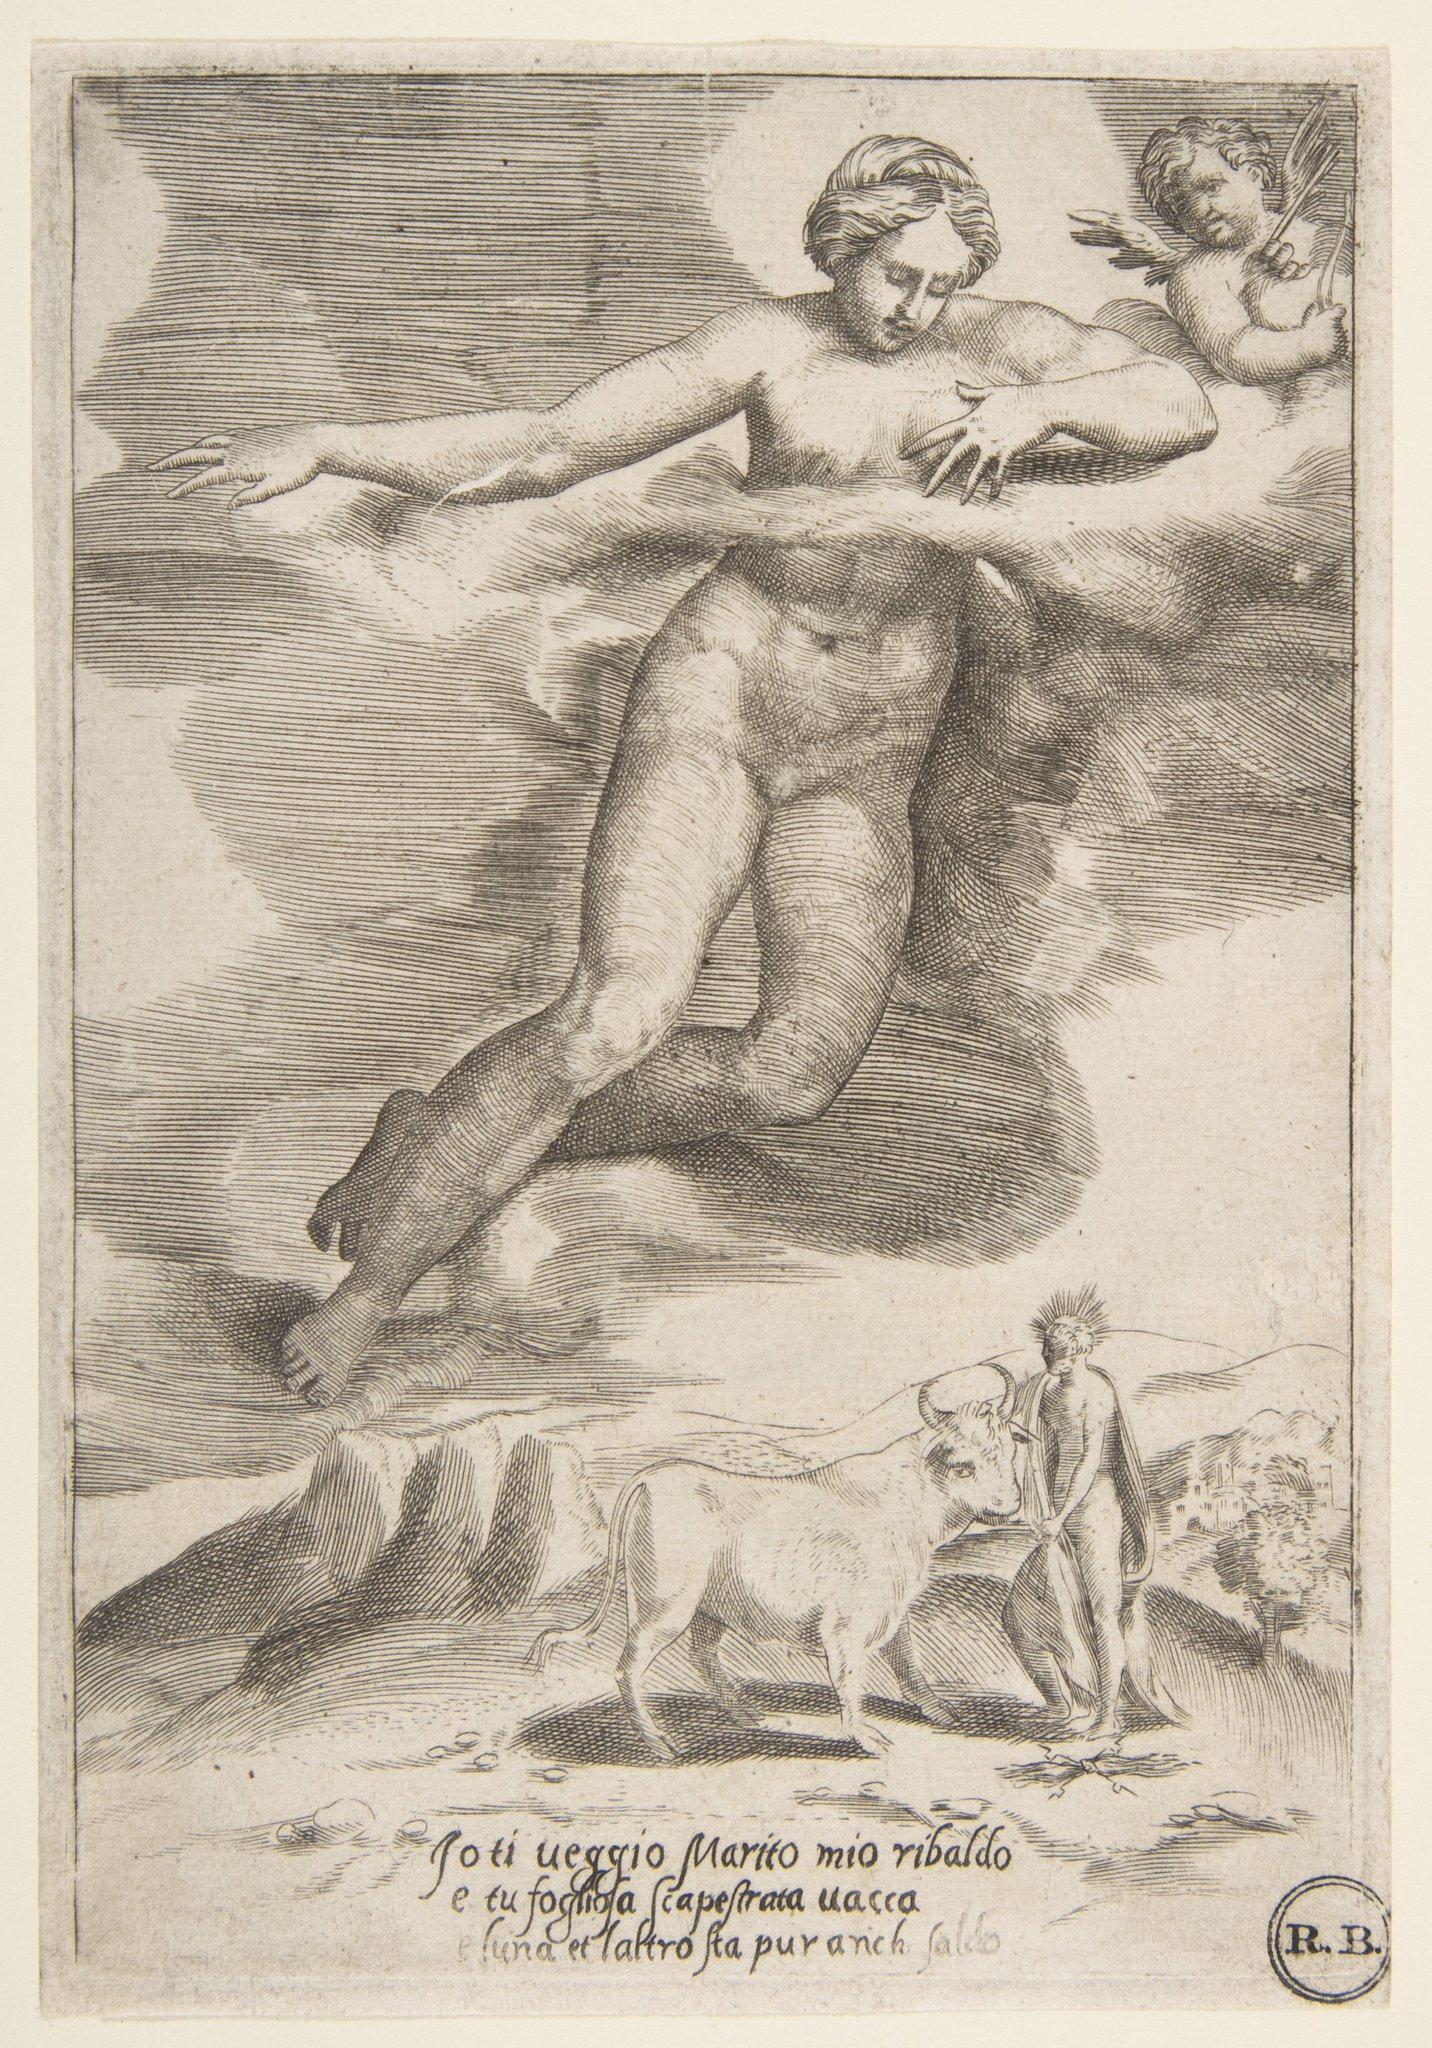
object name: print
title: Juno watching Jupiter and Io, from "The Loves of the Gods"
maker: giulio bonasone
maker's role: artist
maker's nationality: italian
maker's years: 1510-1576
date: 1531-1560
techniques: engraving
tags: putti,juno,jupiter,cows,gods